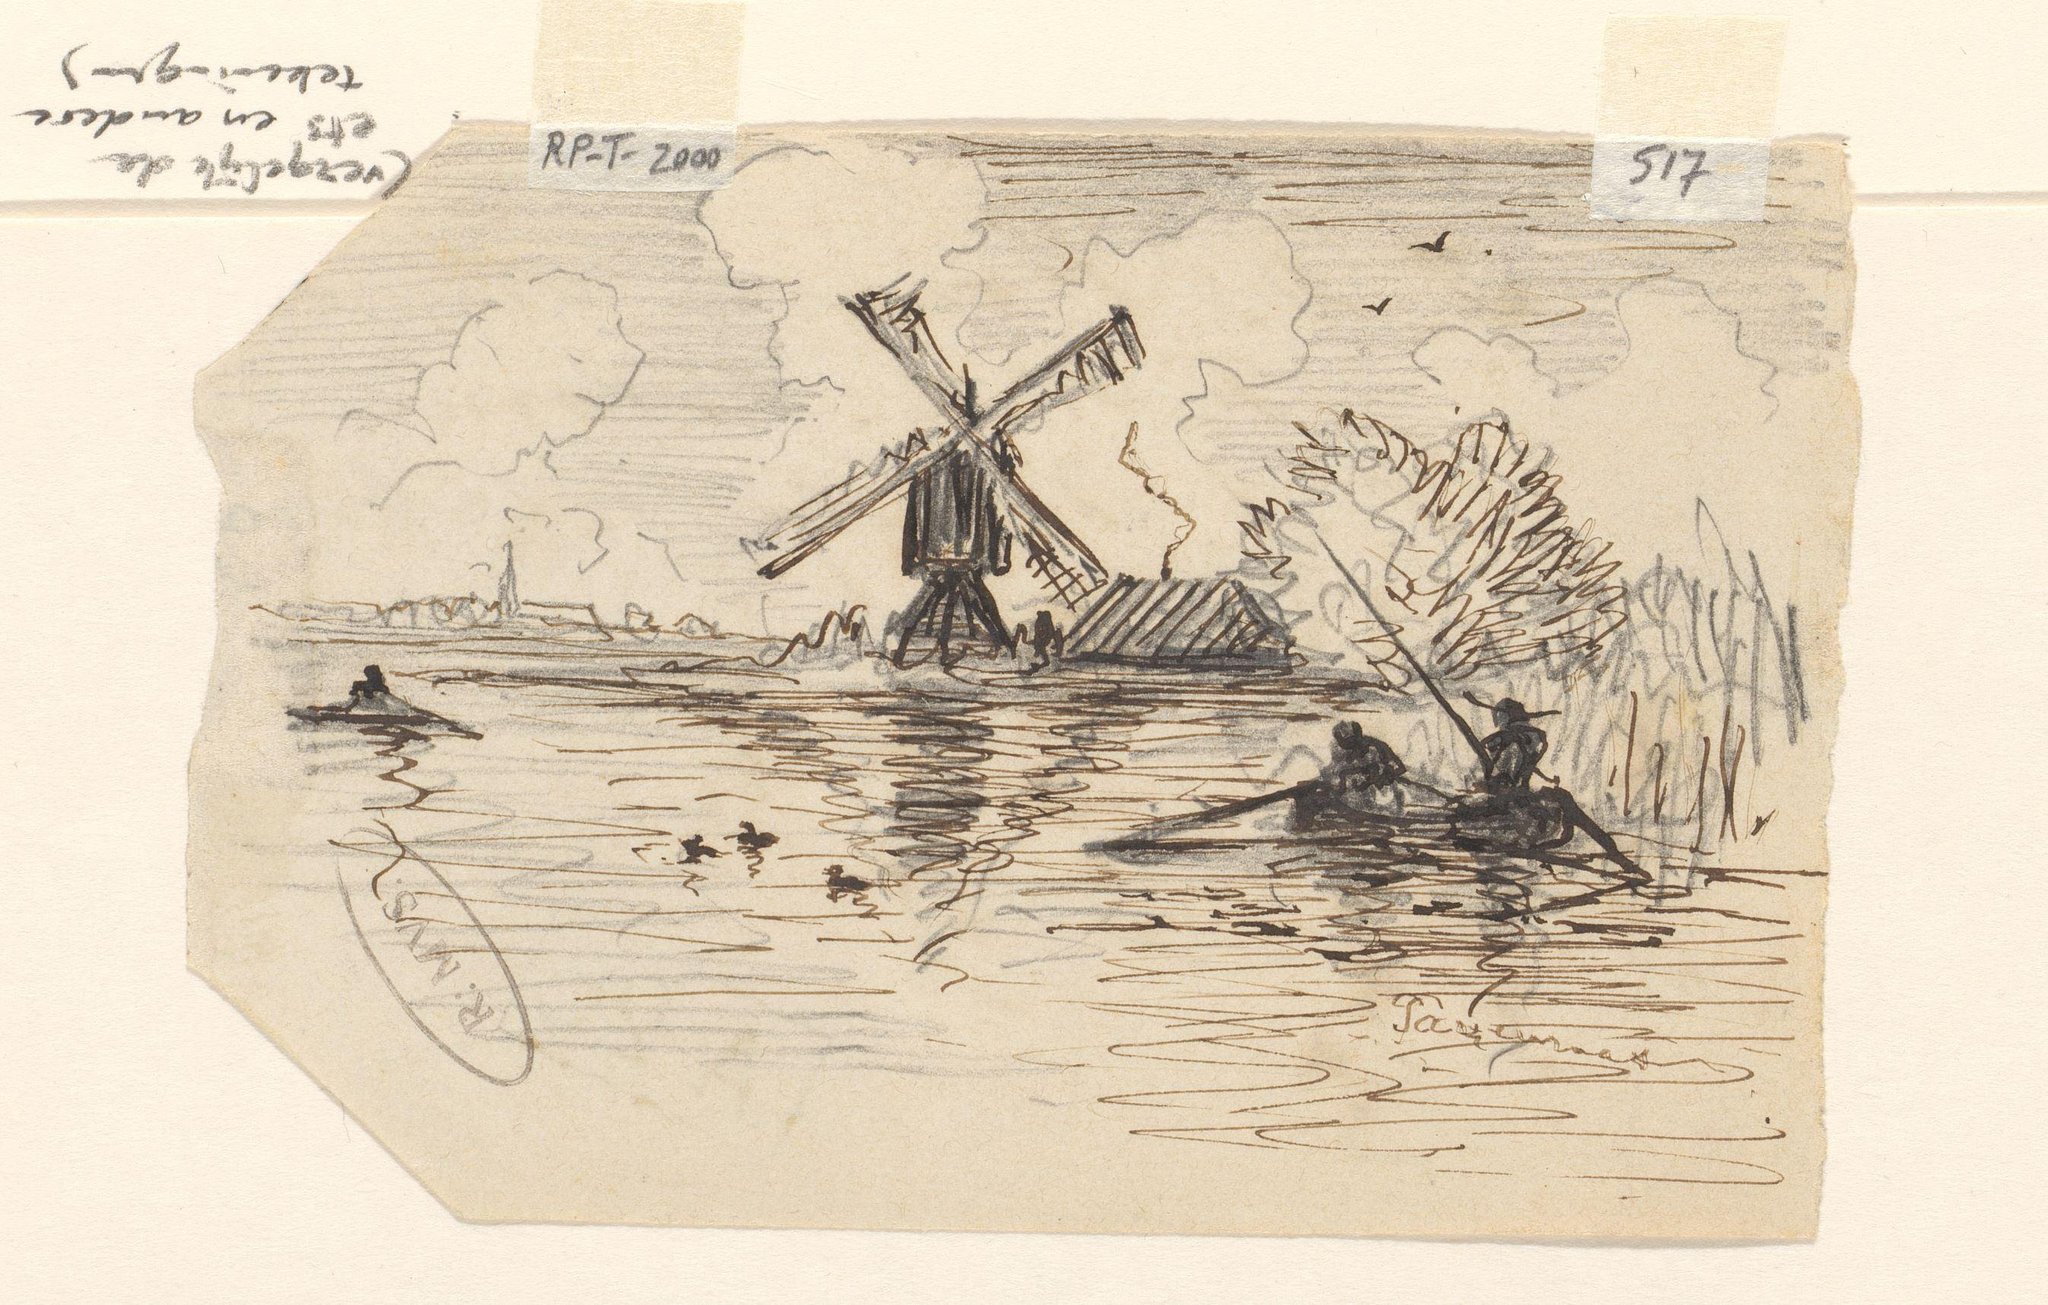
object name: drawing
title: Waterlandschap met molen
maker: johannes tavenraat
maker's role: draughtsman, painter, print maker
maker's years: 1809-1881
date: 1840-1880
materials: ink, paper, pencil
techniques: pen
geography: lübeck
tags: windmill in landscape, river (+ landscape with figures, staffage)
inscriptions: collector's mark: Lugt 2228, signature: ‘Tavenraat’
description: Waterlandschap vissers in een roeiboot, in de verte een molen.